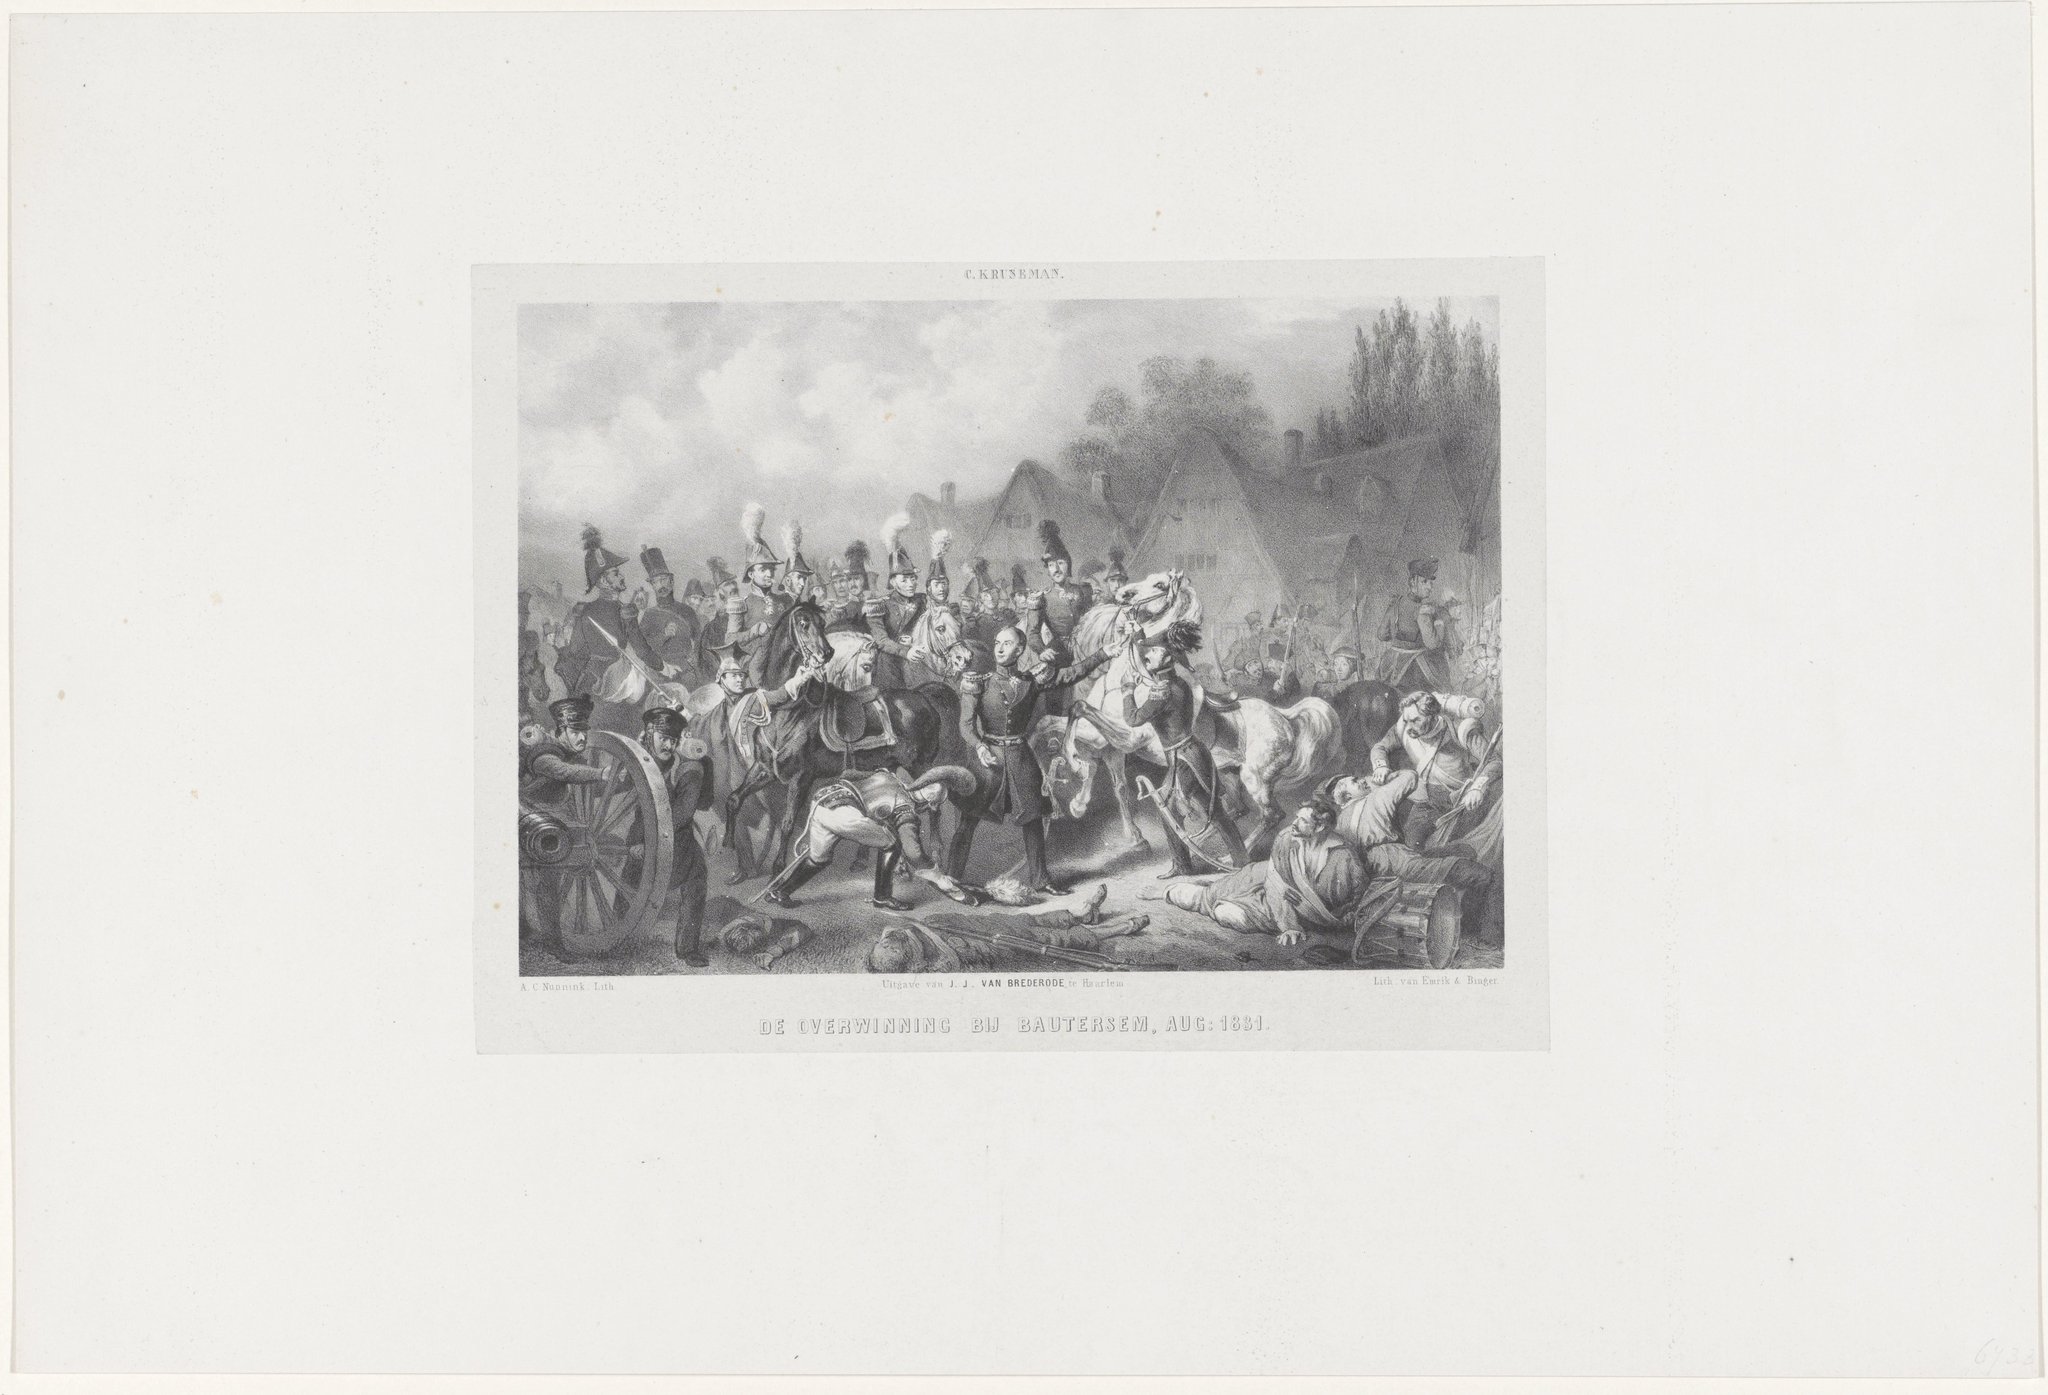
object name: history print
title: De overwinning bij Bautersem, aug: 1831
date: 1855-1860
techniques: printmaking, lithograph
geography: haarlem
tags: the hague, william ii of the netherlands, berlin, frederik (prins der nederlanden), fighting horses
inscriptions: collector's mark: Lugt 2166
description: Overwinning in de slag bij Boutersem, 12 augustus 1831. Centraal staande op de grond de prins van Oranje die zijn paard waarvan een deel van been is afgeschoten verruilt voor een ander paard hem aangereikt door majoor Hoyel. Achter de prins zijn broer Frederik en zijn staf te paard. Links een kanon, op de voorgrond en rechts doden en gewonden.